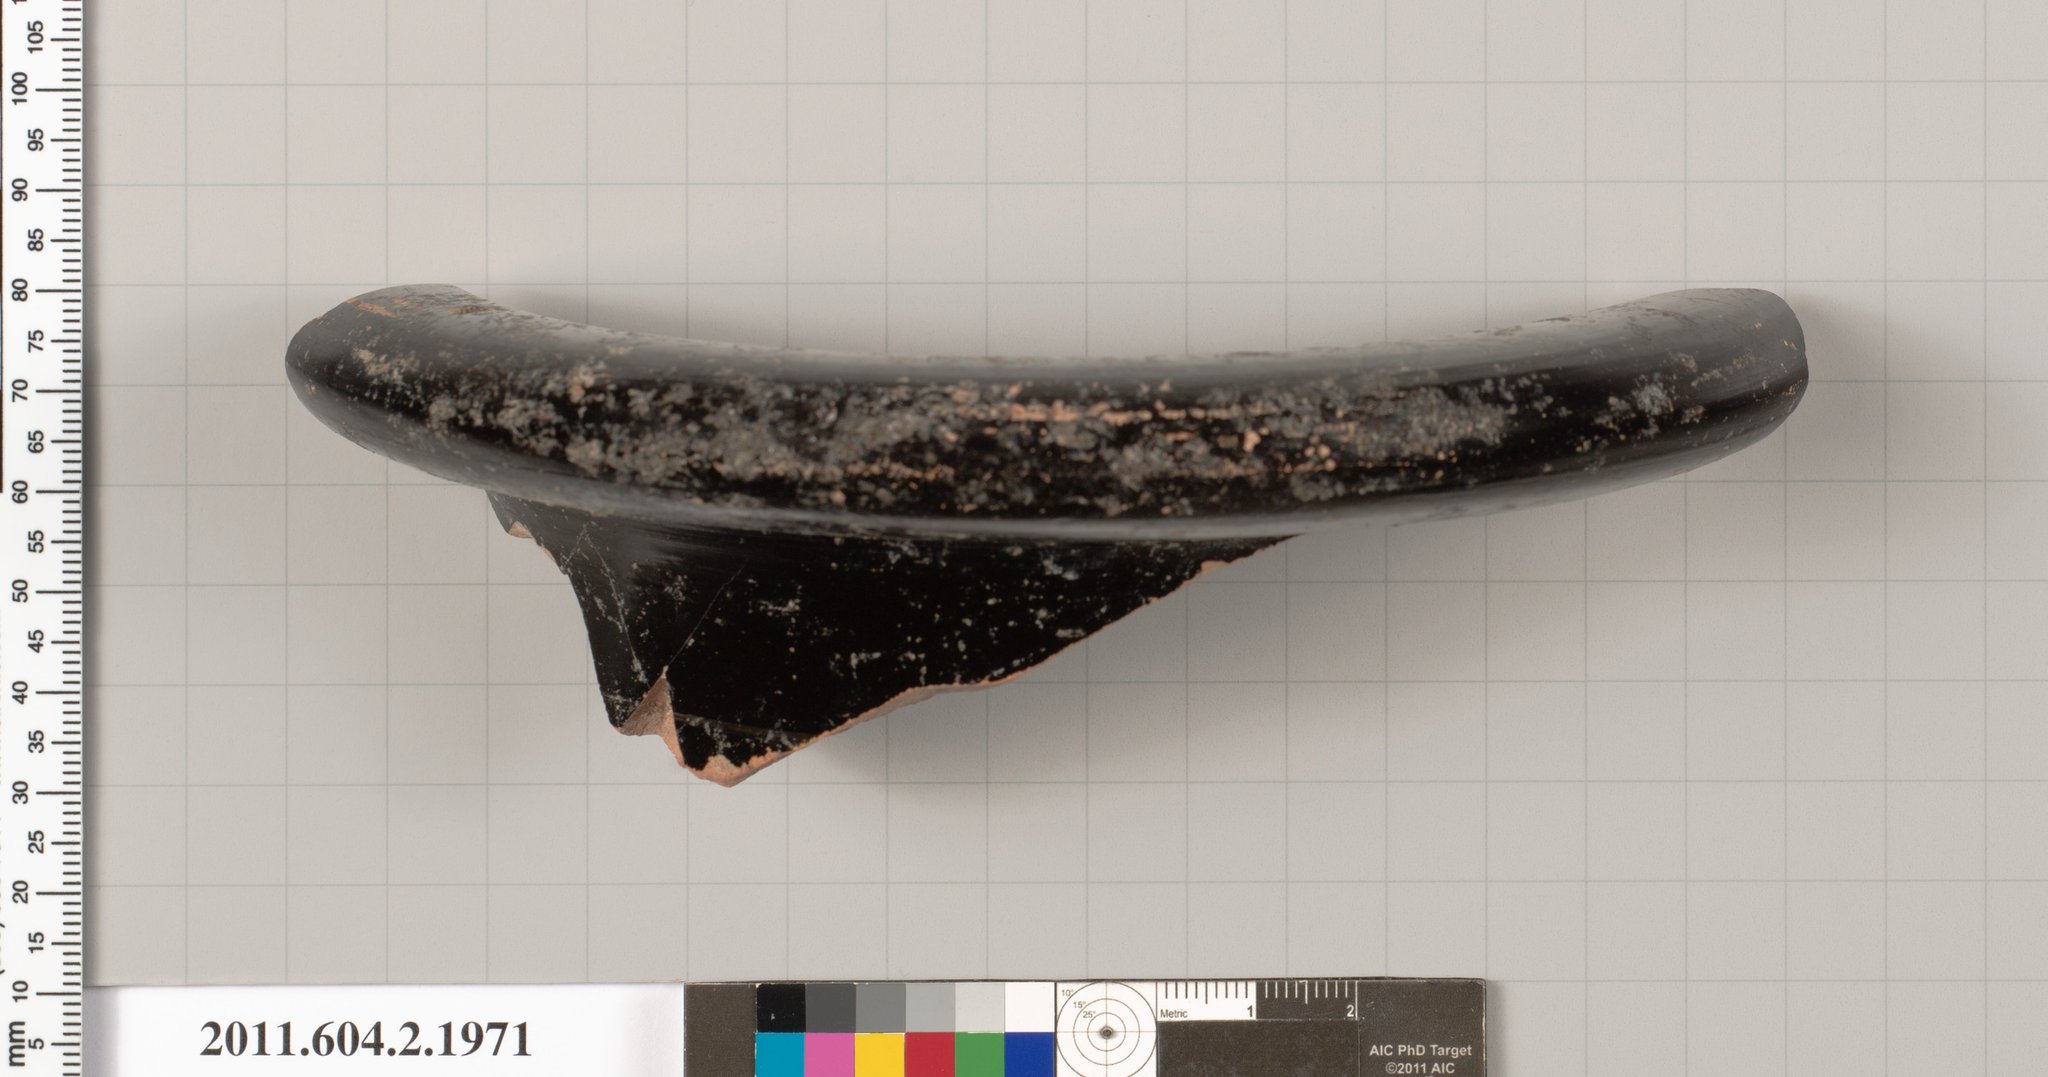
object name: pelike fragment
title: Terracotta fragment of a pelike (jar)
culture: greek, attic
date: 475-451 BCE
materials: terracotta